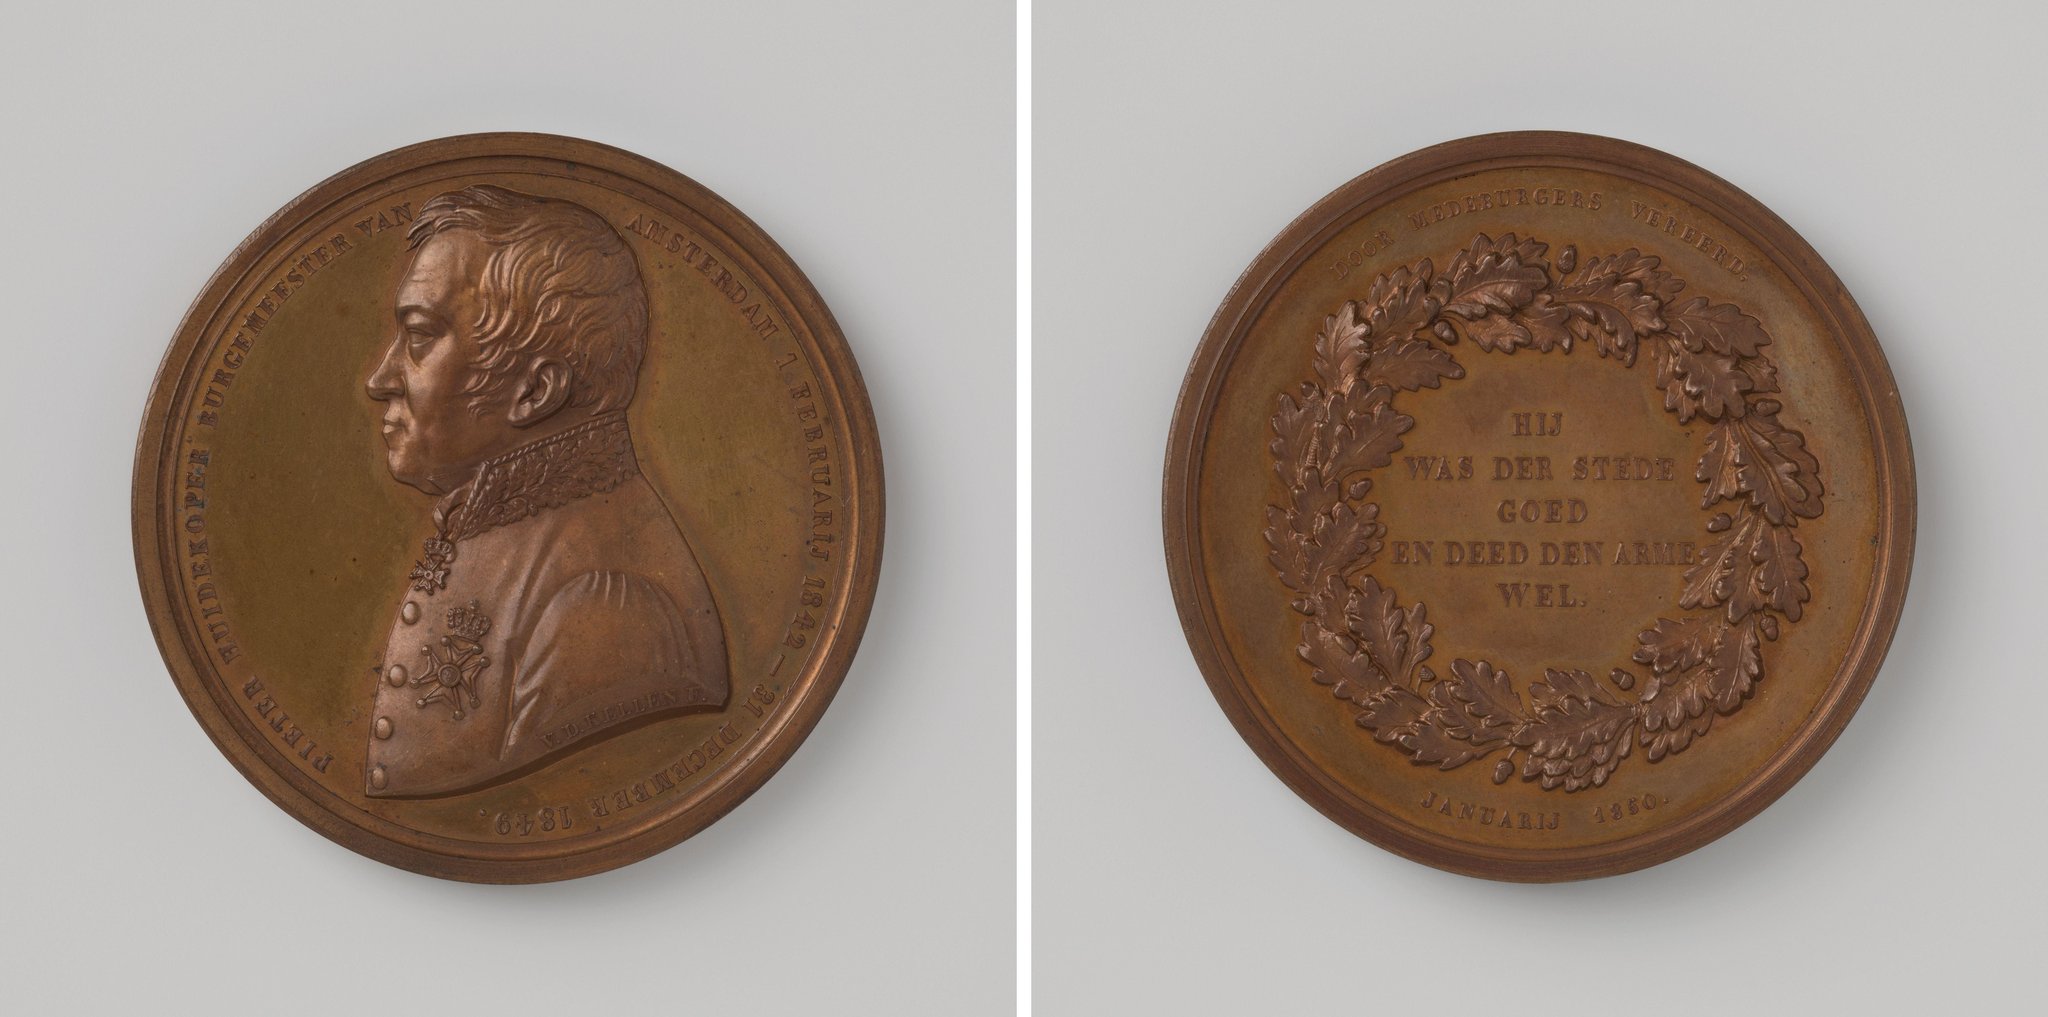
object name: history medal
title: Afscheid van Pieter Huidekoper als burgemeester van Amsterdam 1850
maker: david van der kellen (1804-1879)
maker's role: die cutter, draughtsman, print maker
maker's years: 1804-1879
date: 1850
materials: bronze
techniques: striking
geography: utrecht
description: Bronzen penning, op de voorzijde het geuniformeerde borstbeeld van Huidekoper naar links met omschrift, op de keerzijde vier regels tekst binnen een eikenkrans, met onder en boven omschrift.